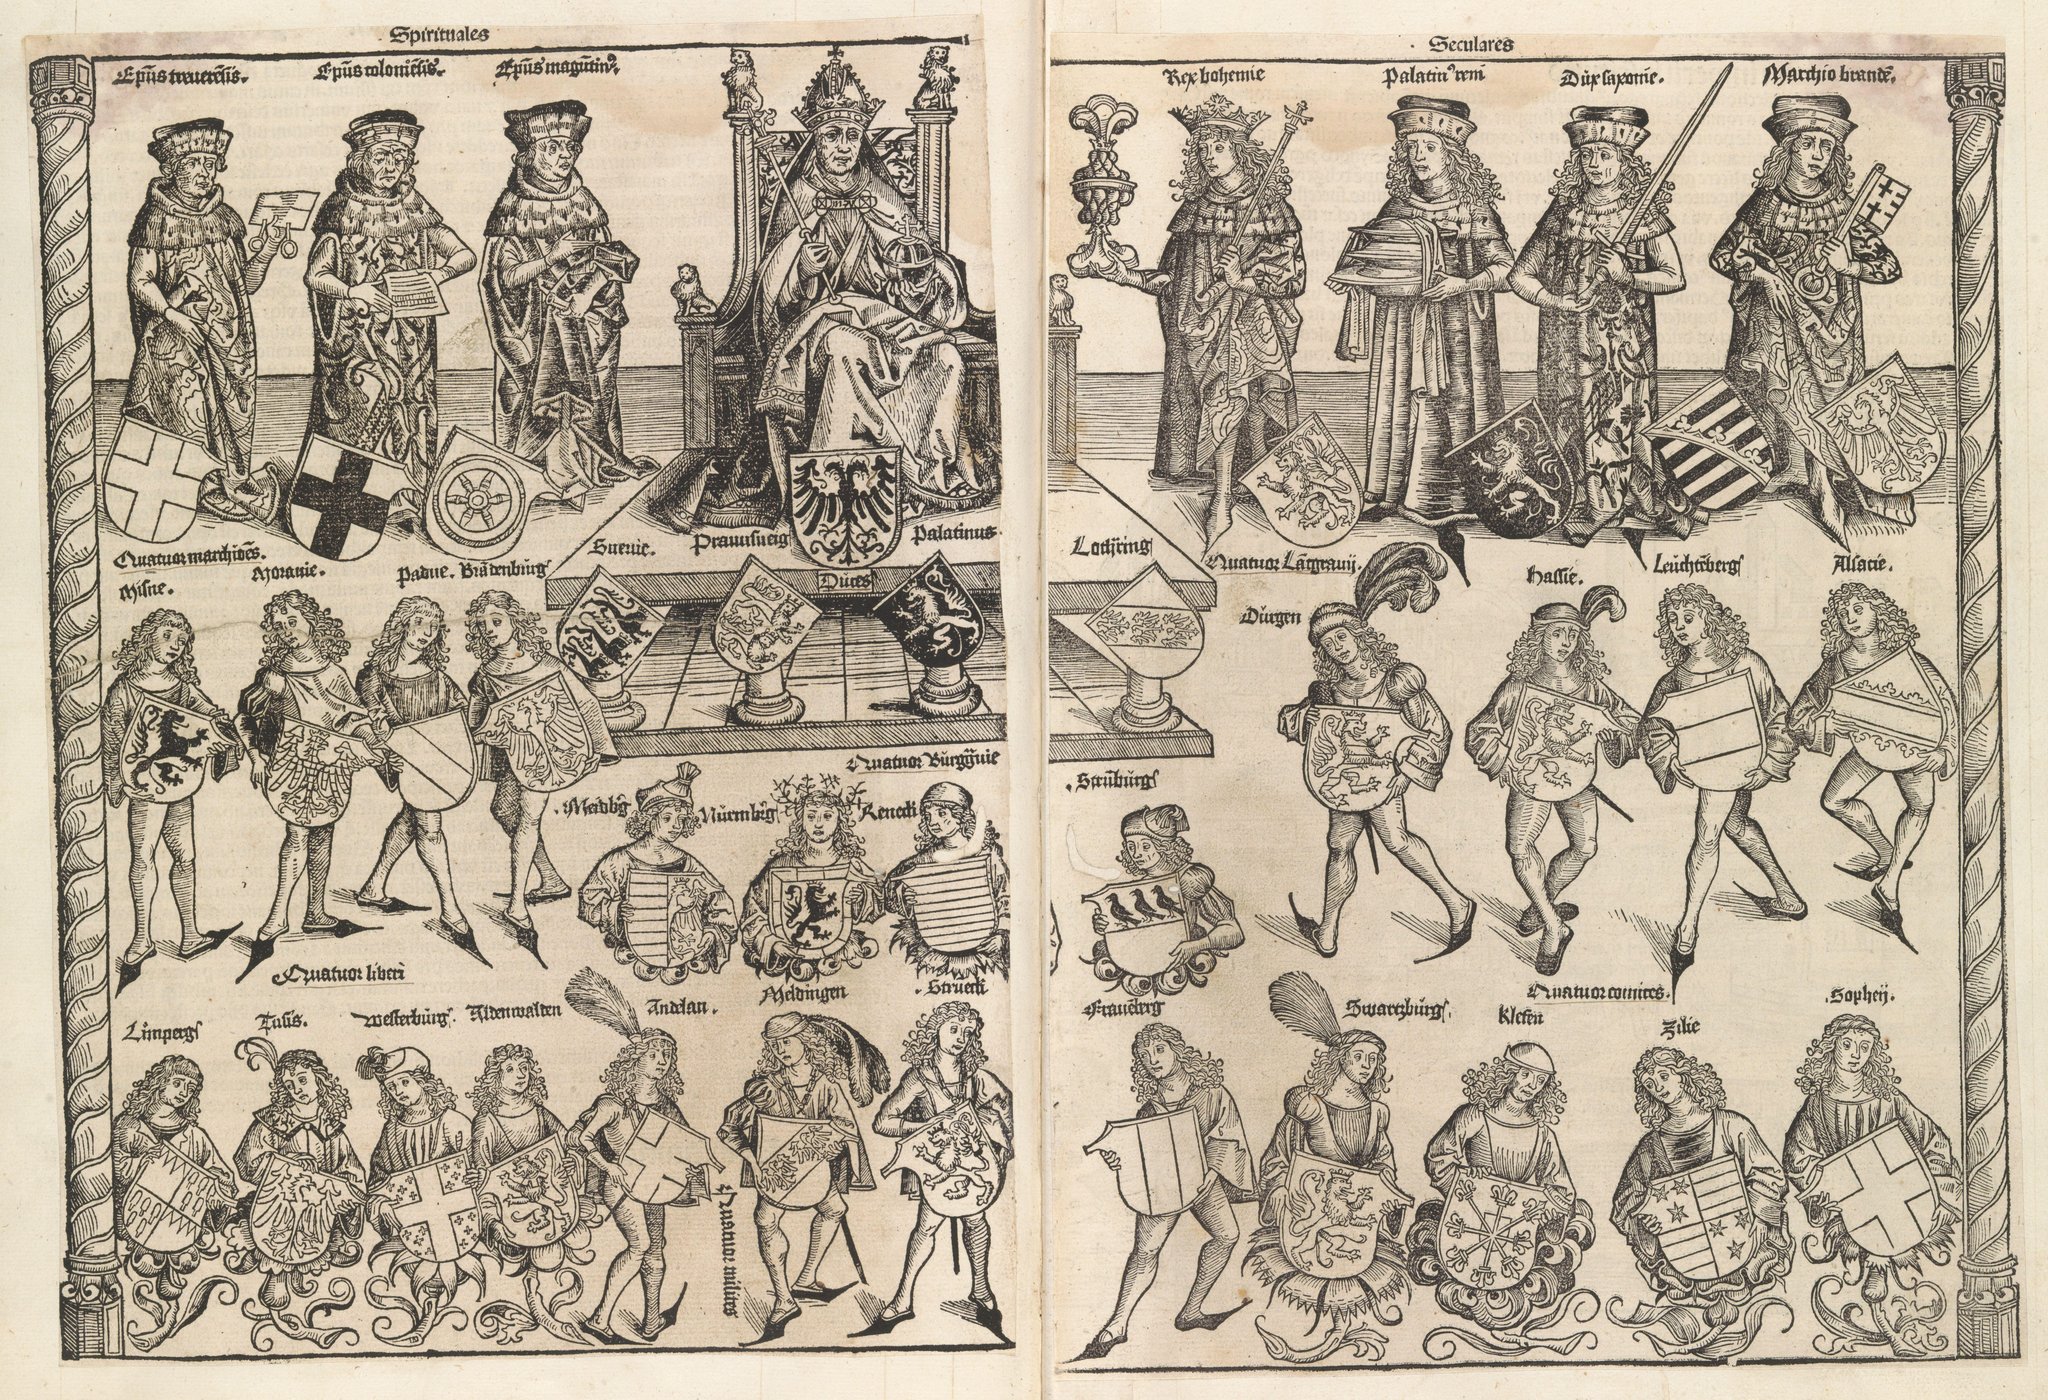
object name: print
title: Keizersverkiezing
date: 1493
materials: paper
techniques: letterpress printing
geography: nuremberg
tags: coat of arms (as symbol of the state, etc.), emperor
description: Dubbelbladige voorstelling (hier in twee delen) uit de Liber Chronicarum. Ze toont de Duitse keizer als hoofd van het Heilige Roomse Rijk. Hij zit in keizerlijk gewaad, met scepter en rijksappel, op een troon. Voor hem het keizerlijk wapenschild met de dubbelkoppige adelaar. Zijn troon staat op een podium dat wordt ondersteund door vier pilaren. Ze vertegenwoordigen de vier hertogdommen van Duitsland: Zwaben (drie zwarte gekroonde leeuwen), Brunswijk (twee luipaarden), Palts (een klimmende leeuw tegen een zwarte achtergrond) en Lotharingen (drie adelaars op een diagonale balk). De keizer wordt geflankeerd door zijn drie geestelijke en vier seculiere keurvorsten. Links staan de aartsbisschop van Trier, Keulen en Mainz. Ze hebben elk een document in hun handen. Rechts staan de koning van Bohemen, de Paltsgraaf aan de Rijn, de hertog van Saksen en de markgraaf van Brandenburg. De eerste heeft een scepter en een grote gouden beker in zijn handen. De tweede draagt drie schotels en een servet. De derde heeft een zwaard in zijn handen en de laatste een sleutel. De attributen verwijzen naar hun aartsambten in het ceremoniële keizerlijke huishouden, achtereenvolgens dat van aartsschenker, aartsseneschalk, aartsmaarschalk en aartskamerheer. In de tweede en derde rij volgen afbeeldingen van jonge mannen, ten voeten uit of busteportretten met wapenschilden. Het gaat om verschillende groepen: vier markgraven, vier burggraven en vier landgraven, vier ridderschappen en vier graafschappen. De prent maakt deel uit van een album.